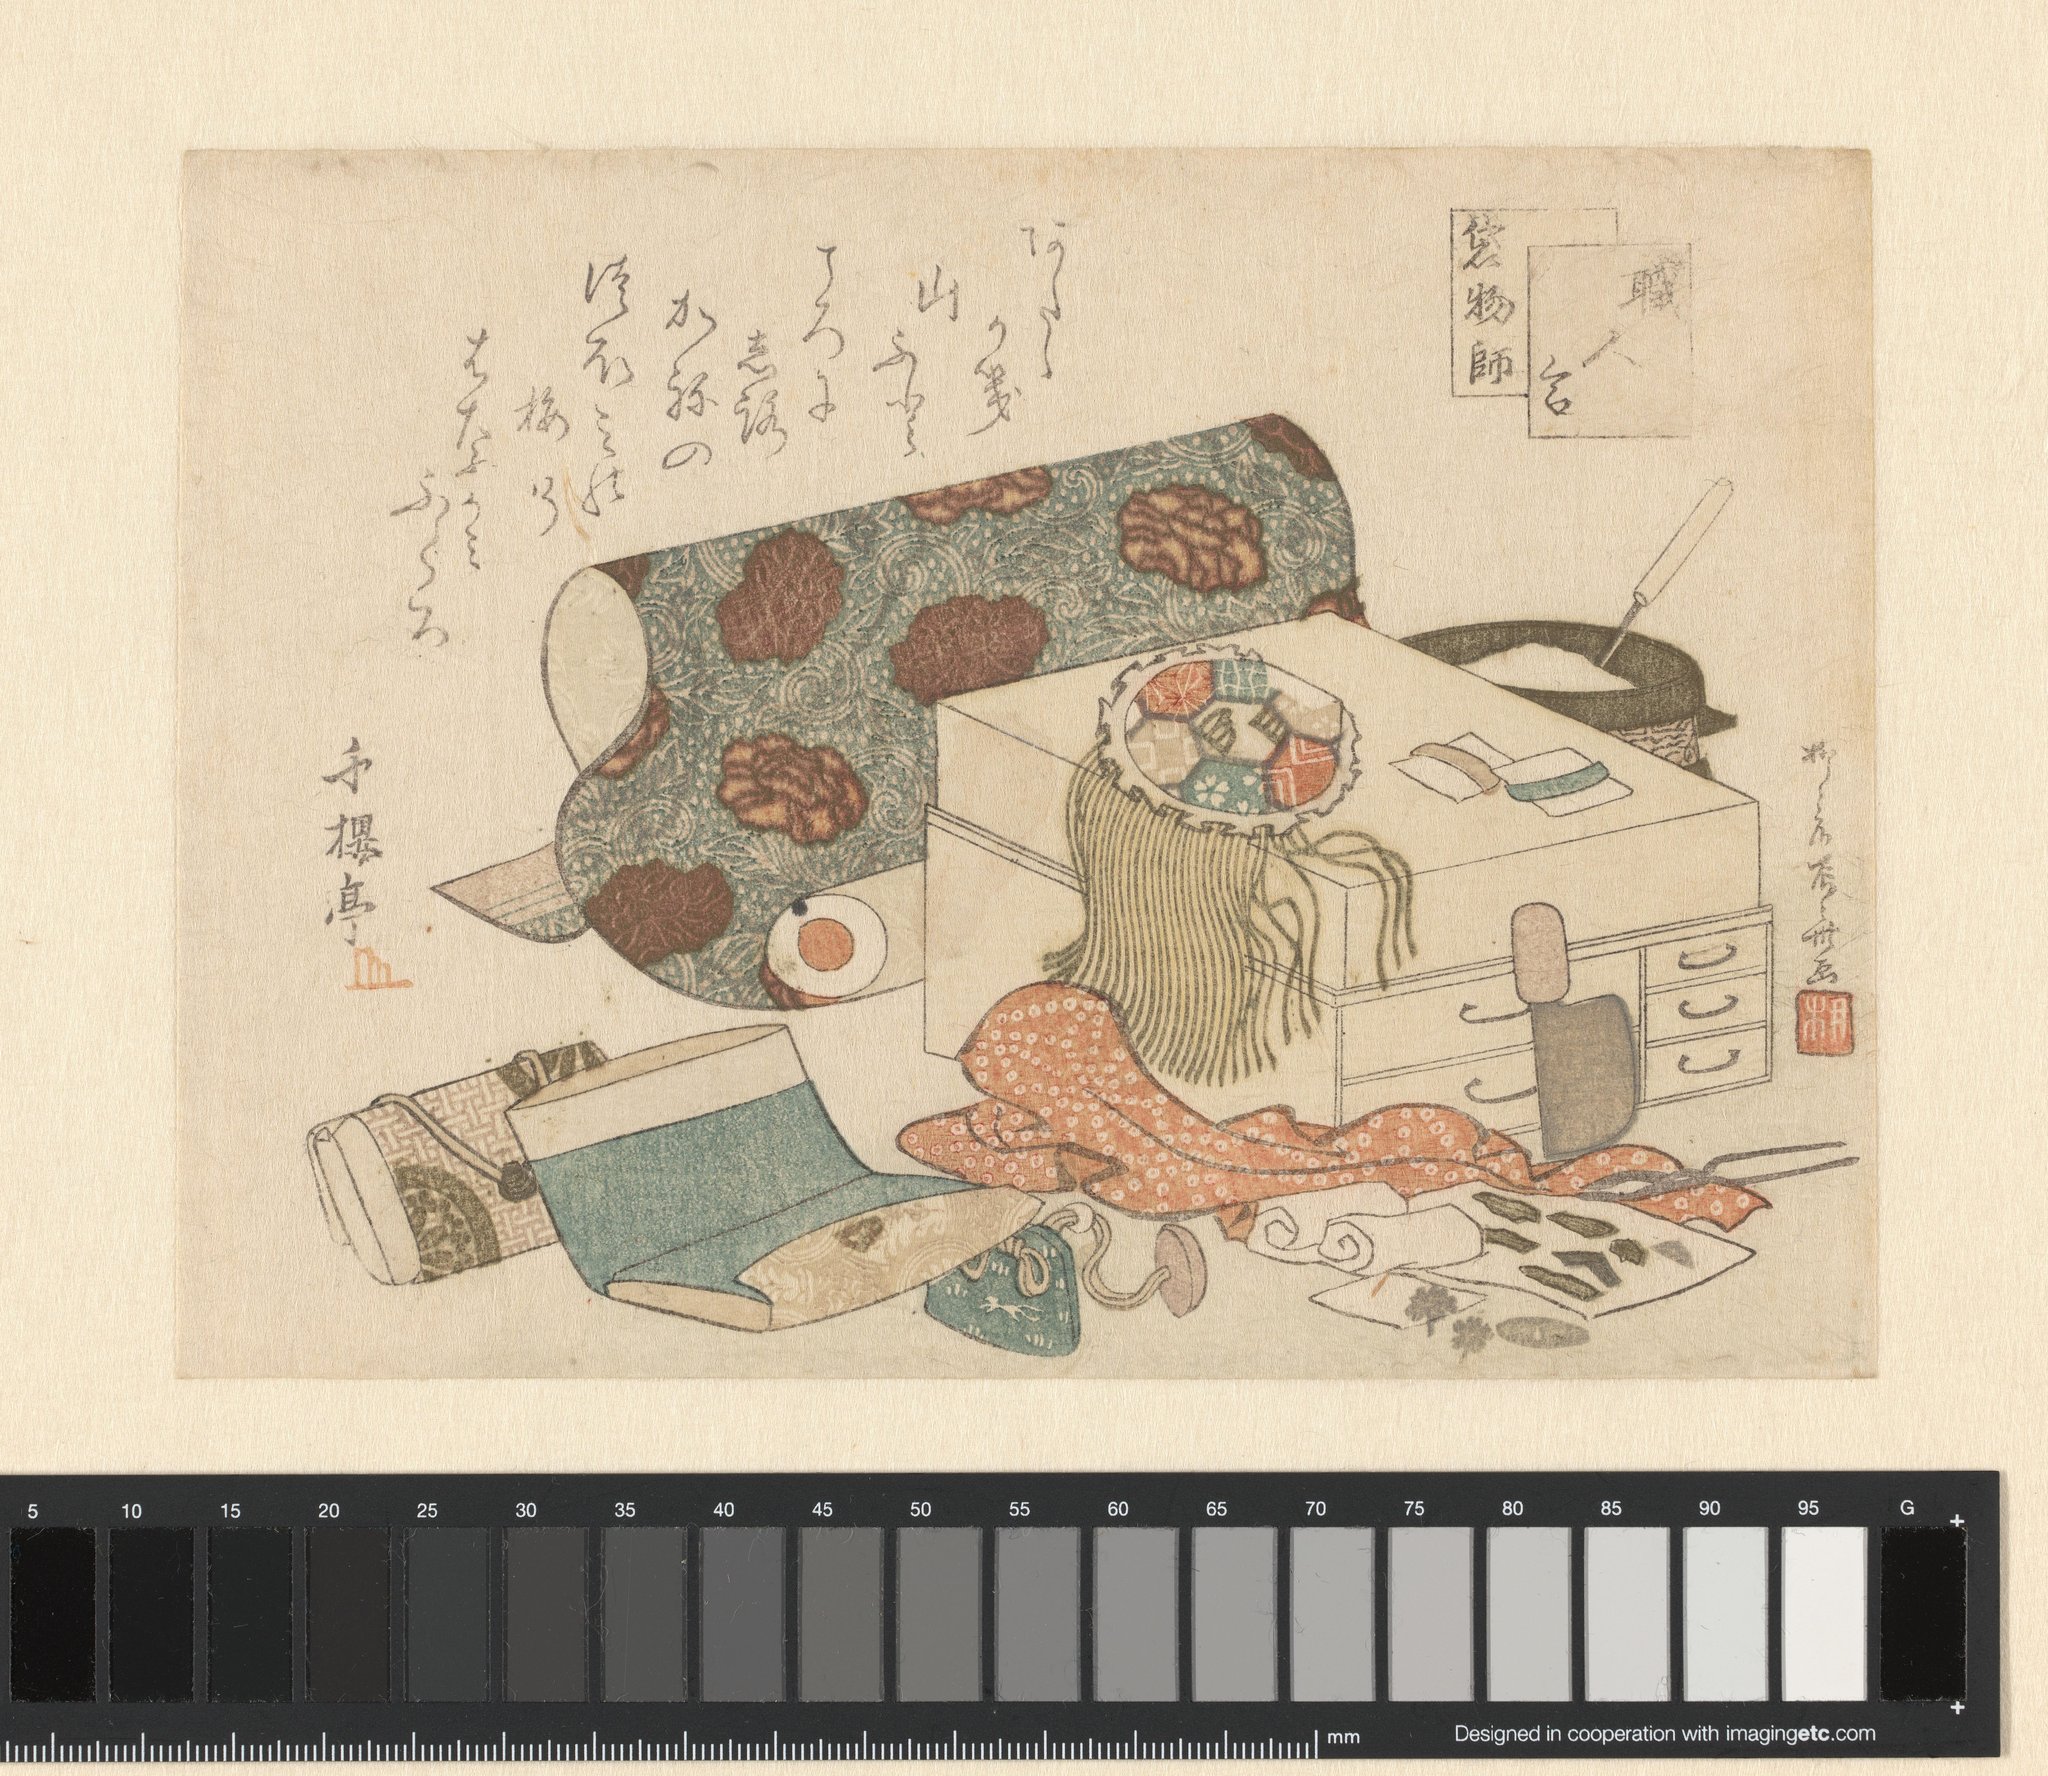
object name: surimono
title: Stof en borduursel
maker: ryûryûkyo shinsai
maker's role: draughtsman, print maker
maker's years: 1764-1825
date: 1820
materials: paper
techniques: woodcut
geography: japan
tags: still life of related objects, sewing box, sewing